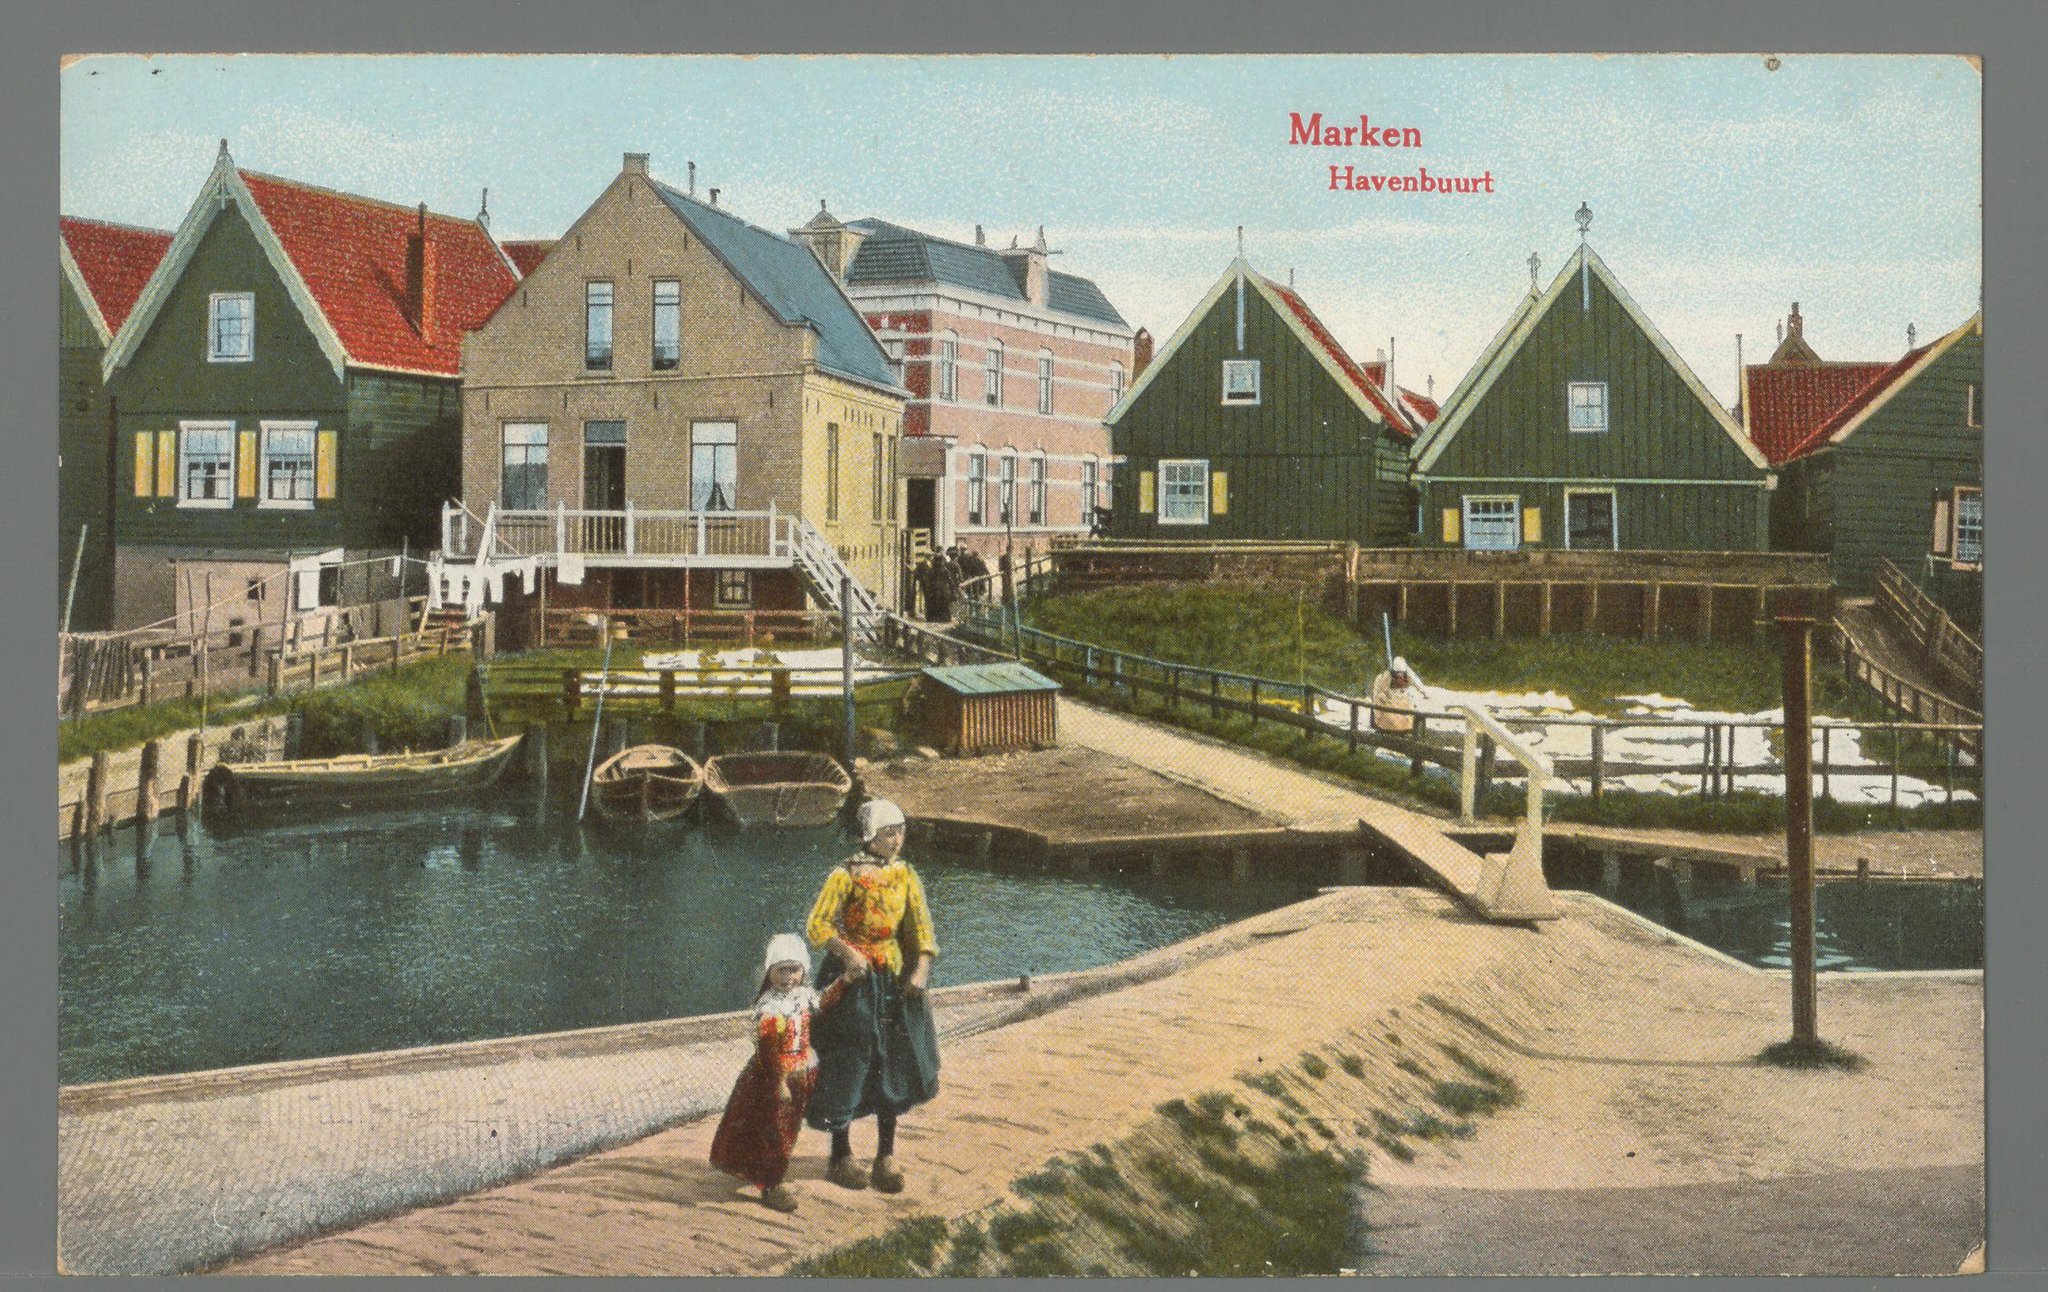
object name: photomechanical print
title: Marken Havenbuurt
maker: Anonymous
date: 1918-1927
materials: cardboard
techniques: lithograph, writing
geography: marken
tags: harbour, city-view, and landscape with man-made constructions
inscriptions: postage stamp